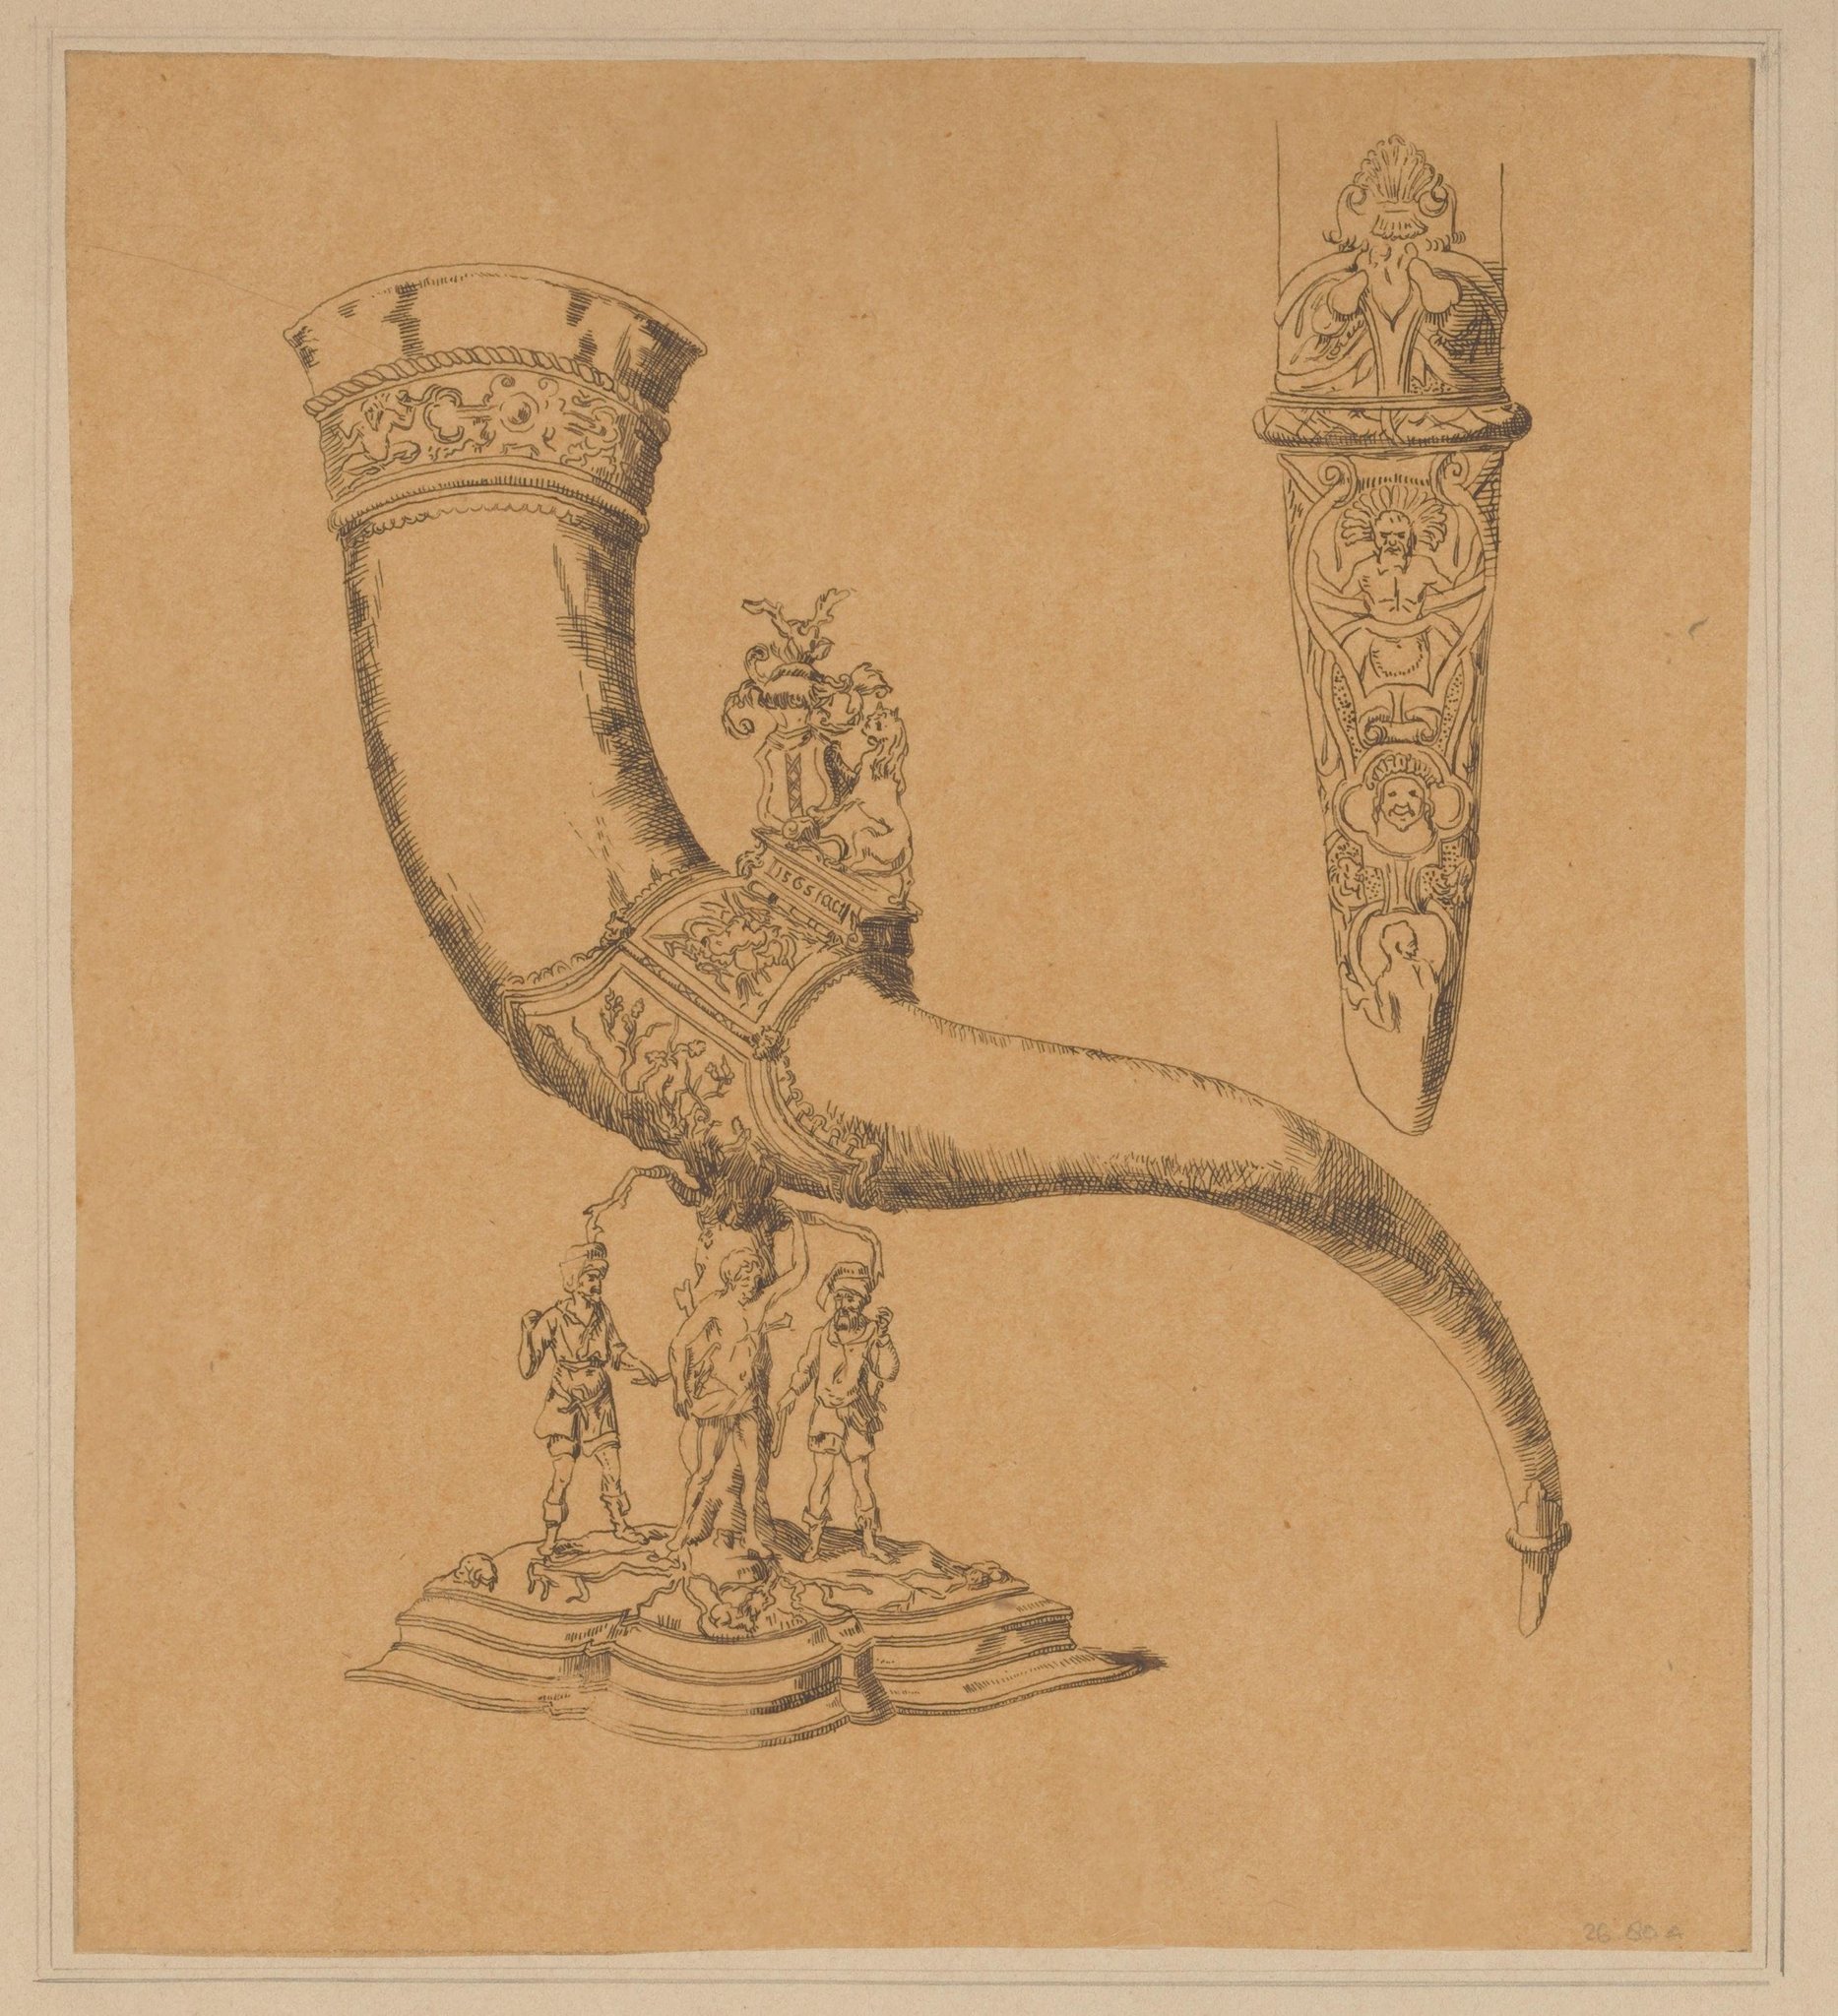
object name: drawing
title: Drinkhoorn van het handboogschuttersgilde van Amsterdam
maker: Anonymous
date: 1801-1900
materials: ink, paper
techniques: pen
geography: netherlands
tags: insignia of a guild, drinking-horn, amsterdam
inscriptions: collector's mark: Lugt 1641b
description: Volledig object en detail van het zilversmeedwerk. Onderwerpsrubriek binnen de Atlas Amsterdam: Herinneringen aan de Schutterij.